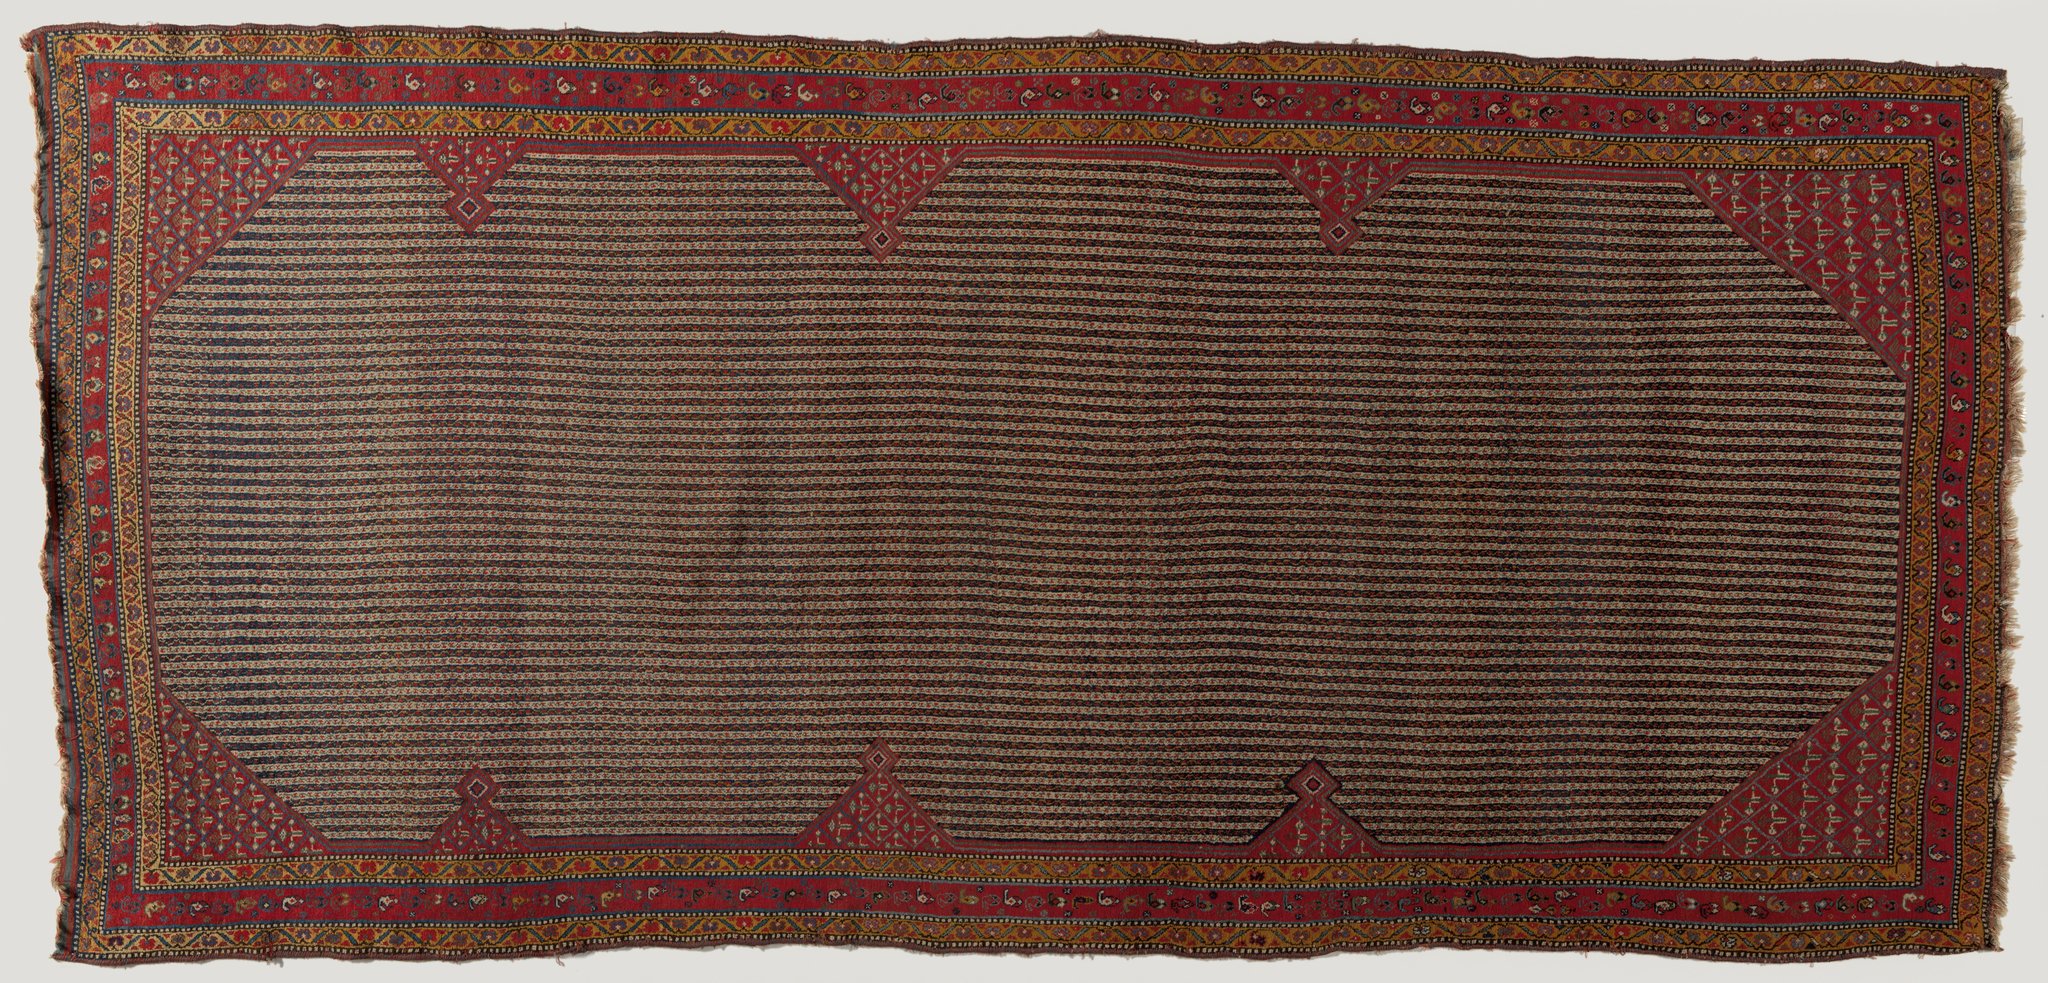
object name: oriental rug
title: Oosters tapijt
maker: khameh wevers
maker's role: tapijtwever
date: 1800-1949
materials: wool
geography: south persia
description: Oosters tapijt van geknoopte wol waarvan het middenveld versierd is donkerblauw en witte strepen met ranken; hoekornamenten. Drie smalle randen waarvan de middelste versierd met botehs. Vervaardigd door Khameh wevers.